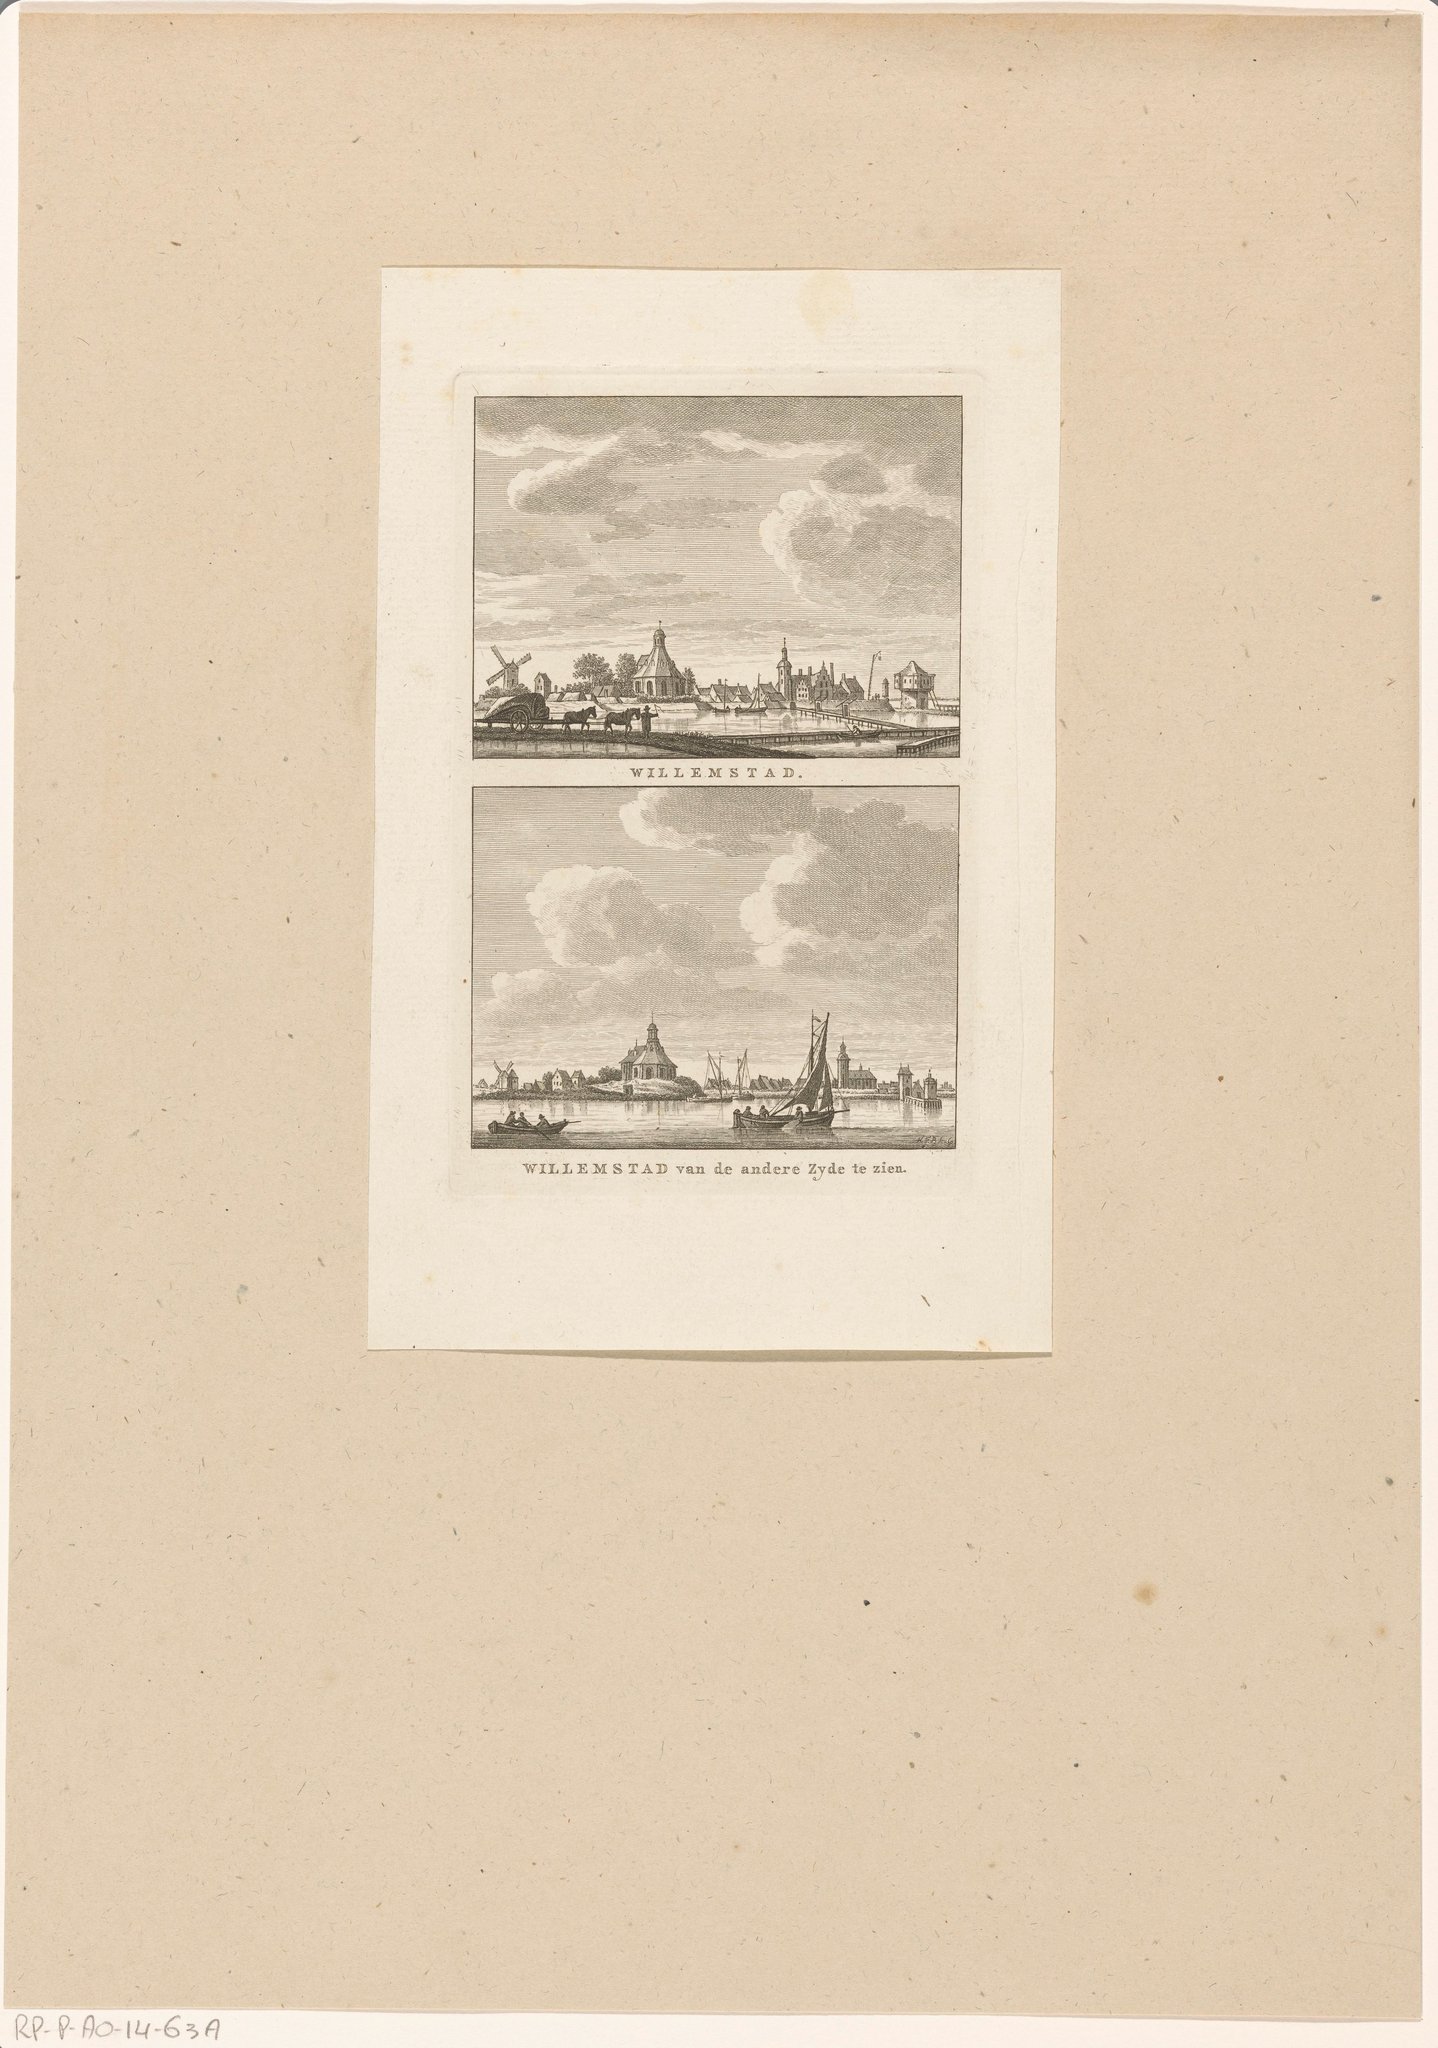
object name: print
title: Willemstad / Willemstad van de andere zyde te zien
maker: carel frederik bendorp (i)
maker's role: print maker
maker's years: 1736-1814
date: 1786-1792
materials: paper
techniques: engraving, etching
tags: sailing-ship, sailing-boat, church (exterior), windmill, prospect of city, town panorama, silhouette of city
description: Prent uit: Vaderlandsche gezichten, of afbeeldingen van den tegenwoordigen staat der Vereenigde Nederlanden (…). Amsterdam: Hendrik Gartman, Willem Vermandel en Jan Willem Smit, 1786-1792. Uitgegeven in afleveringen met ieder een eigen bifolium en inhoudsopgave. Alle prenten in deze publicatie zijn gegraveerd door Carel Frederik Bendorp (I) en, in de meeste gevallen, gebaseerd op tekeningen van Jan Bulthuis.